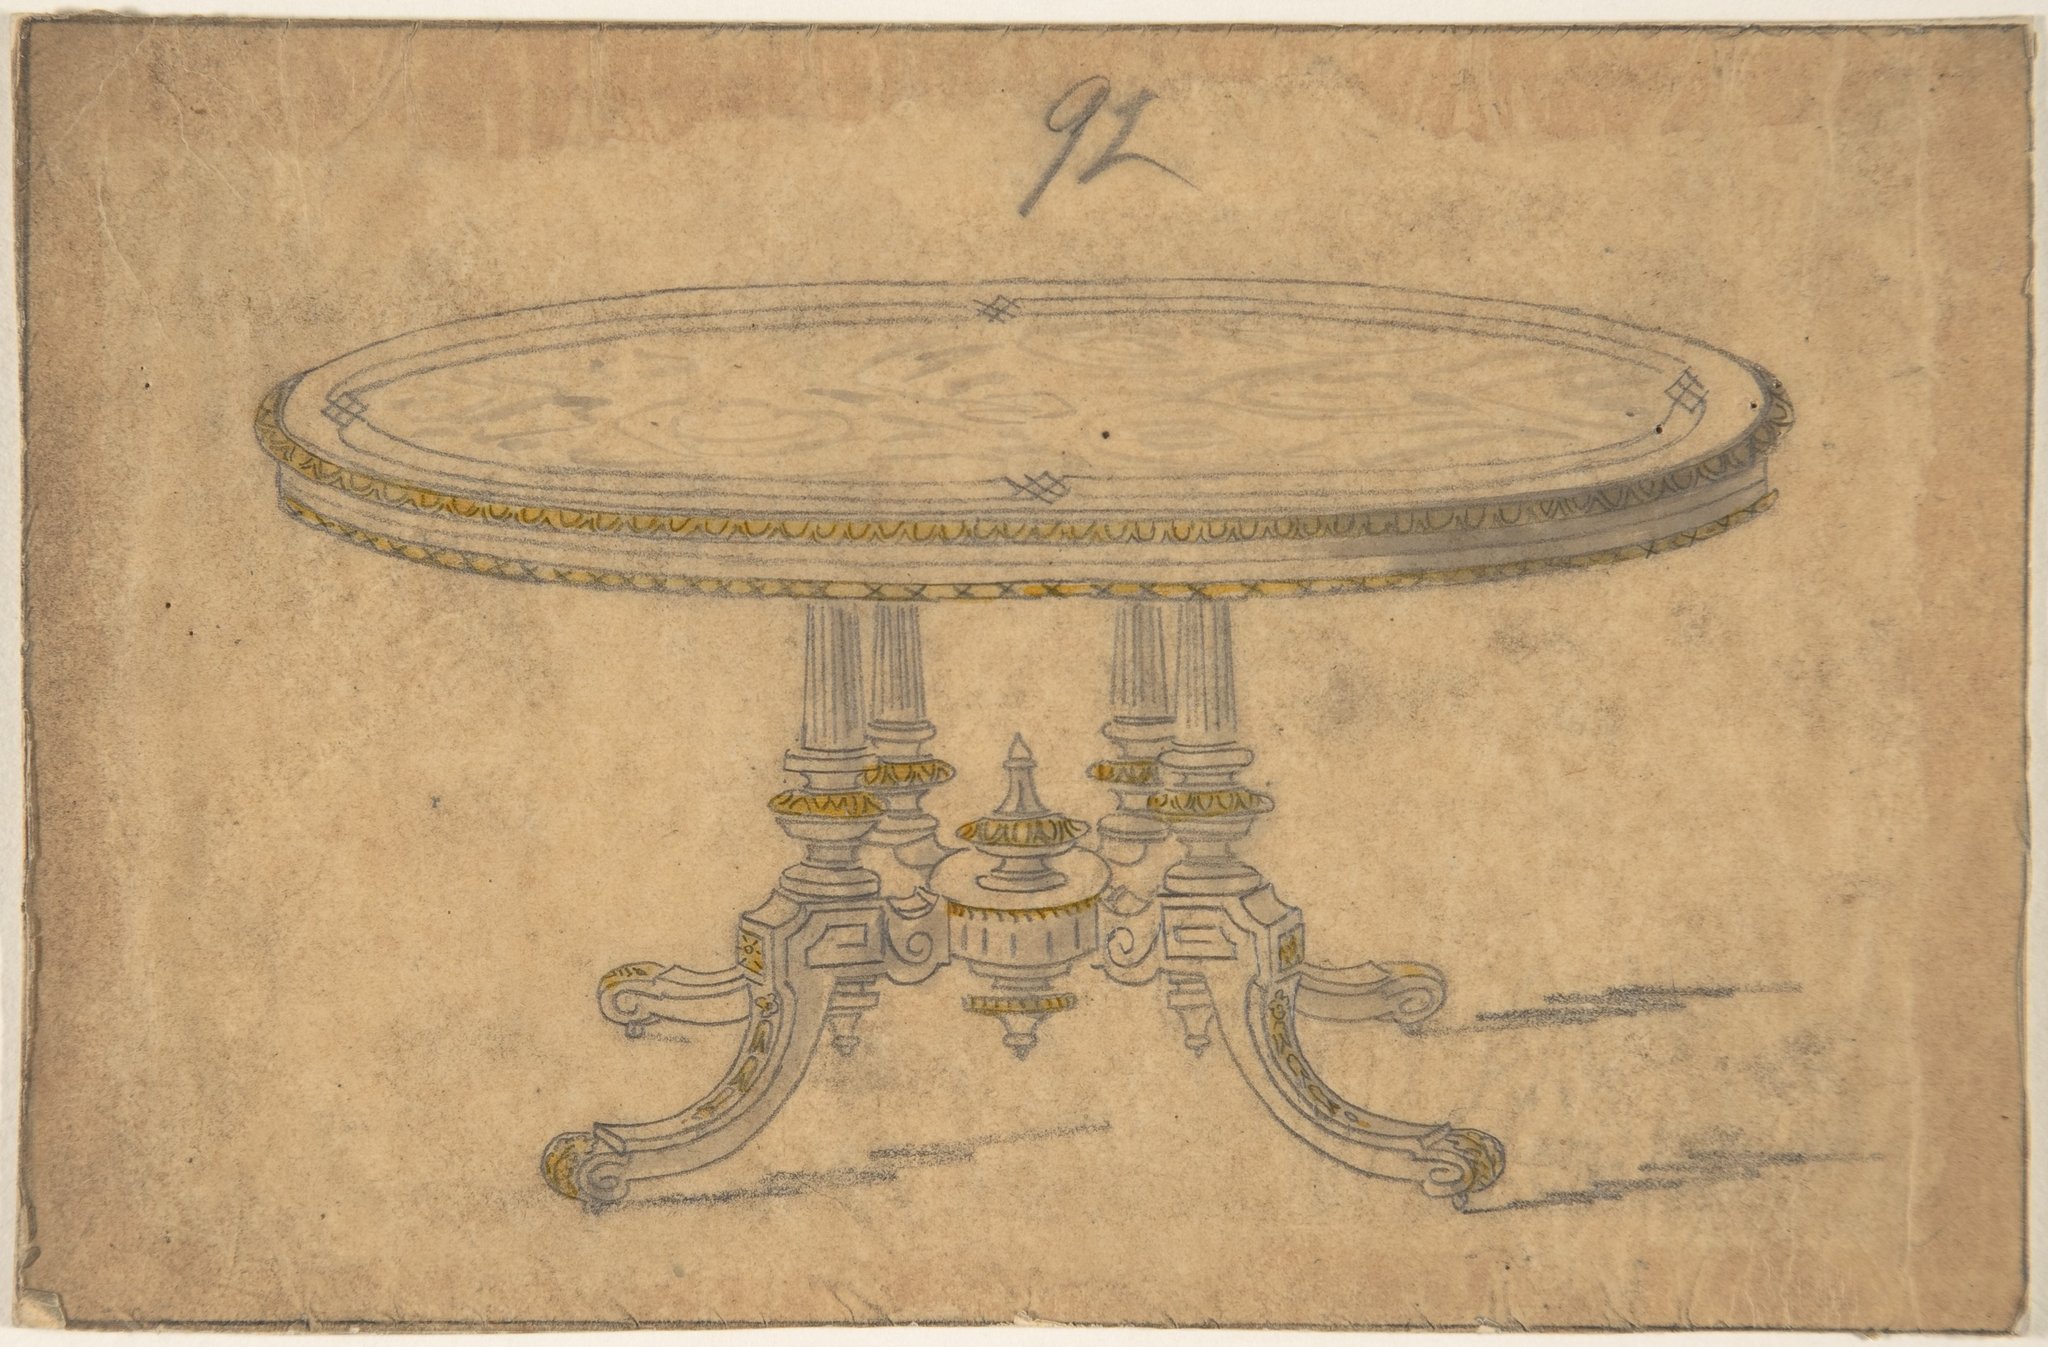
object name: drawing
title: Design for a Round or Oval Renaissance Style Table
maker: anonymous, british, 19th century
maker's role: artist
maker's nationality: british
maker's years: 1800-1900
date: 1801-1900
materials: graphite, paper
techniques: brush, wash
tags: tables